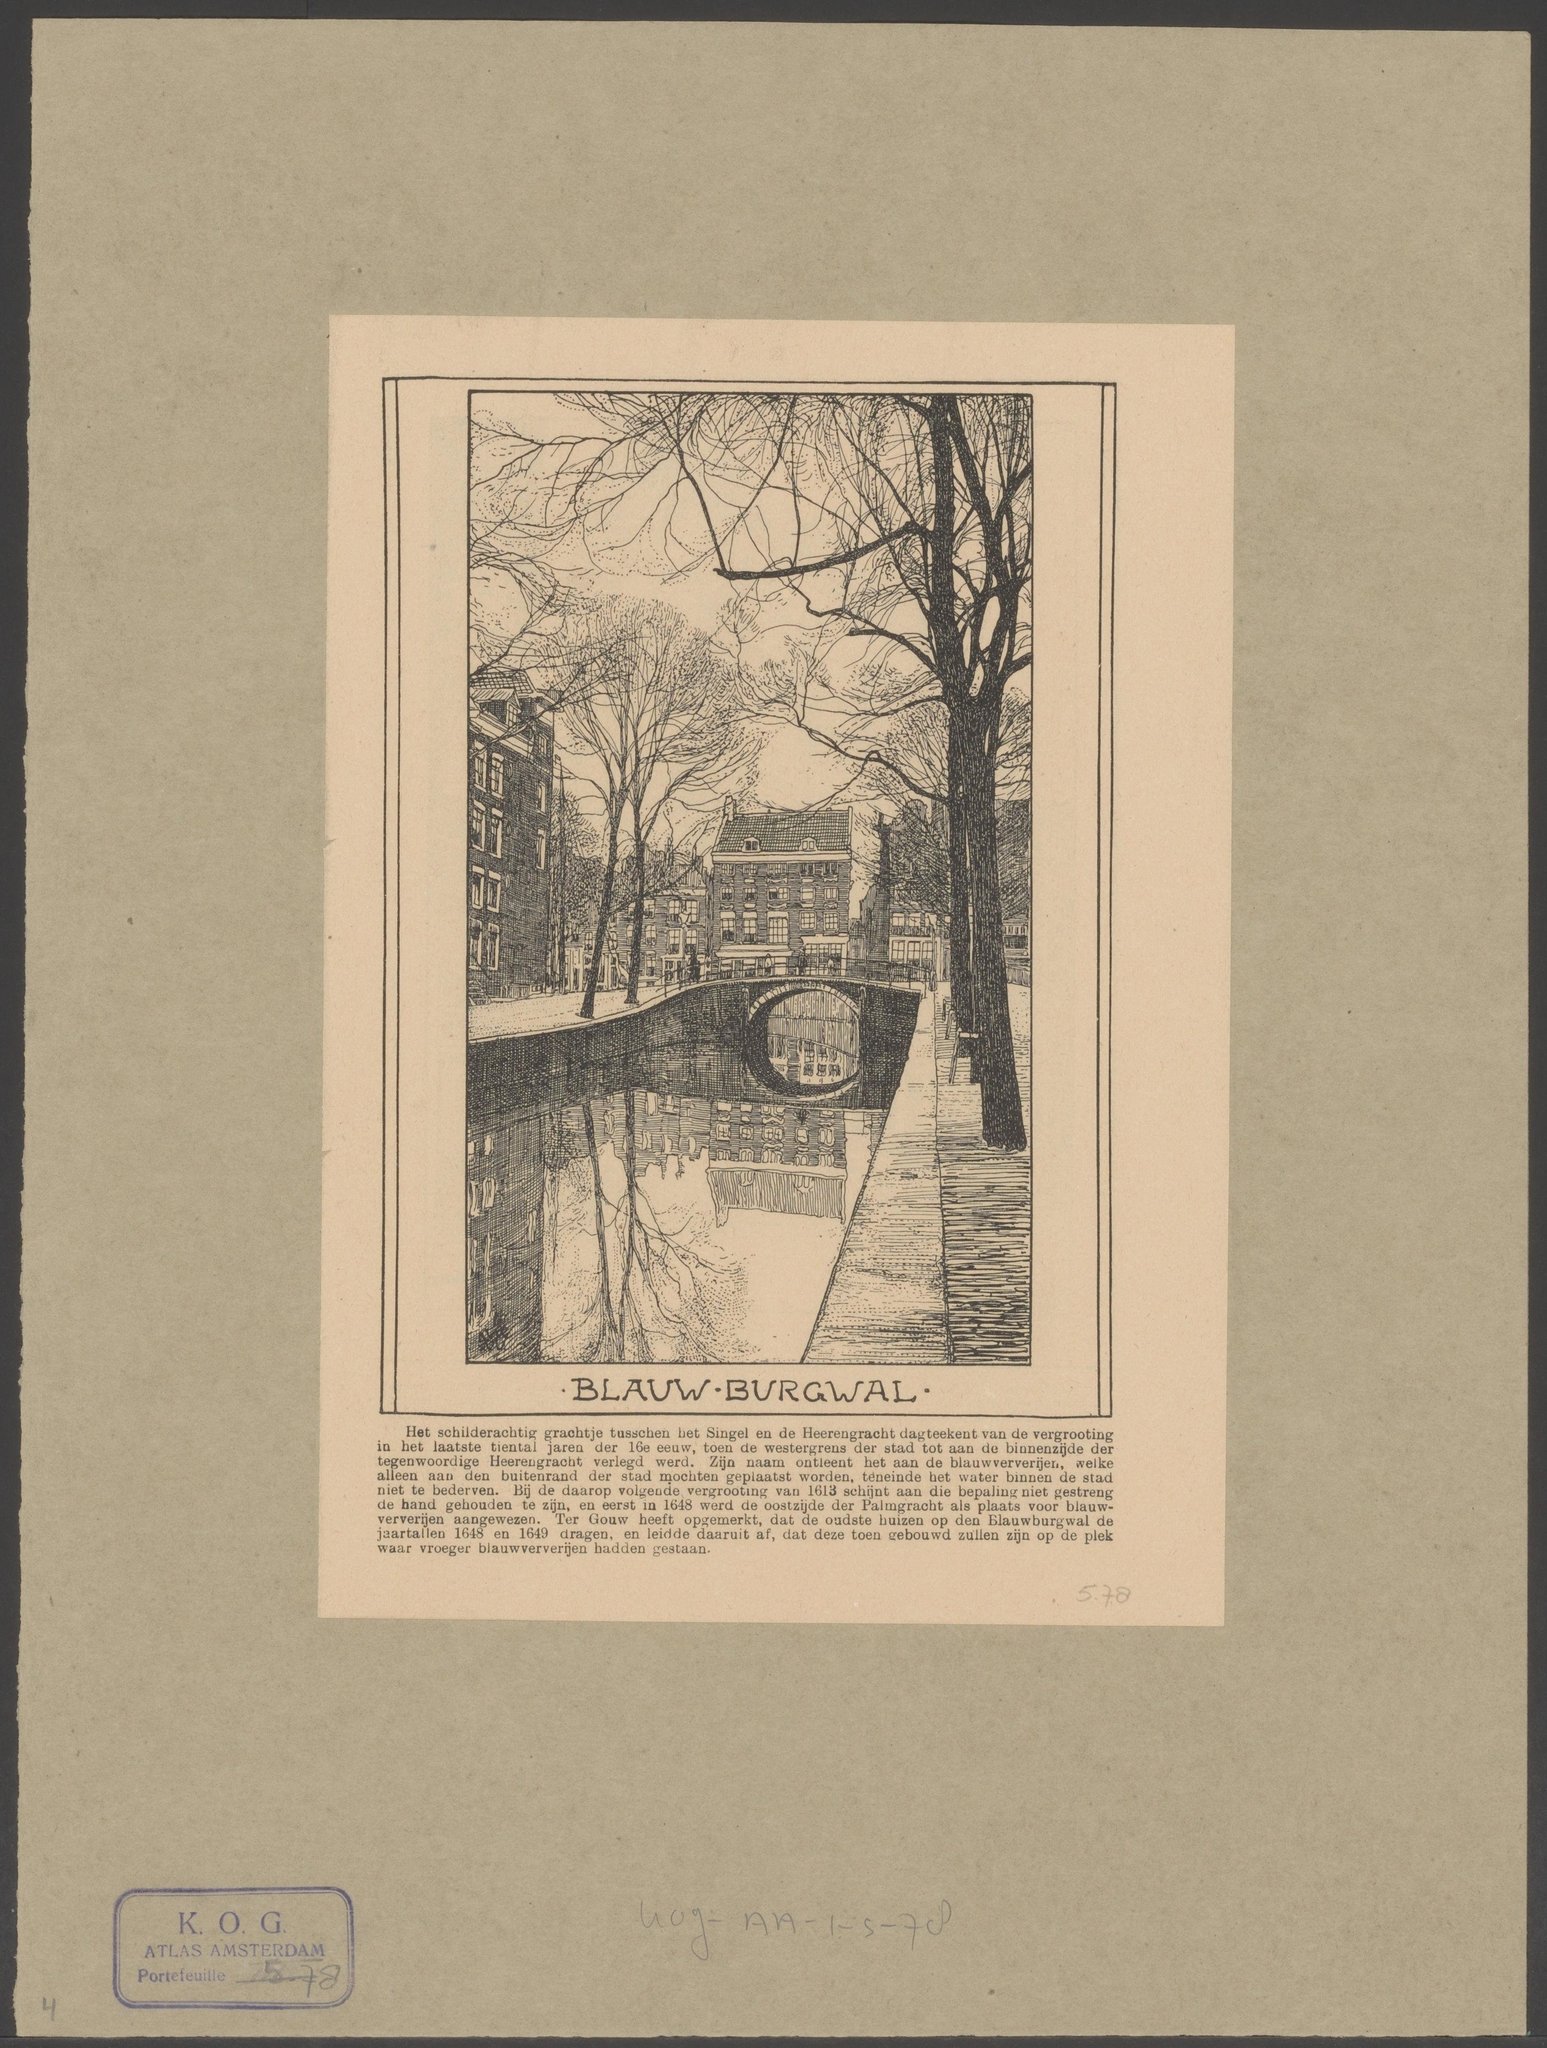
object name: photomechanical print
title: Oud-Amsterdam 100 Stadsgezichten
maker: willem wenckebach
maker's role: designer, draughtsman, painter, print maker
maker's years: 1860-1937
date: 1870-1923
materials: paper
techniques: letterpress printing, line block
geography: amsterdam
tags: city-view in general; 'veduta', canal, bridge in city across river, canal, etc.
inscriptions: collector's mark: ‘5.78’ Lugt 1641b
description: Onderwerpsrubriek binnen de Atlas Amsterdam: Begijnensloot (Gedempte), Bagijnhofsteeg, Beulingsloot, Bickersgracht en –plein, Bickersstraat (Groote), Bilderdijkskade en -straat, Binnenkant, Blauwburgwal, Boomdwarsstraat, Brouwersgracht, Bleekersspad (Lange), Bleekerssloot, Bloemgracht, Boerenwetering, Boltensgrachtje, Boomssloot (Recht), Badhuisweg.